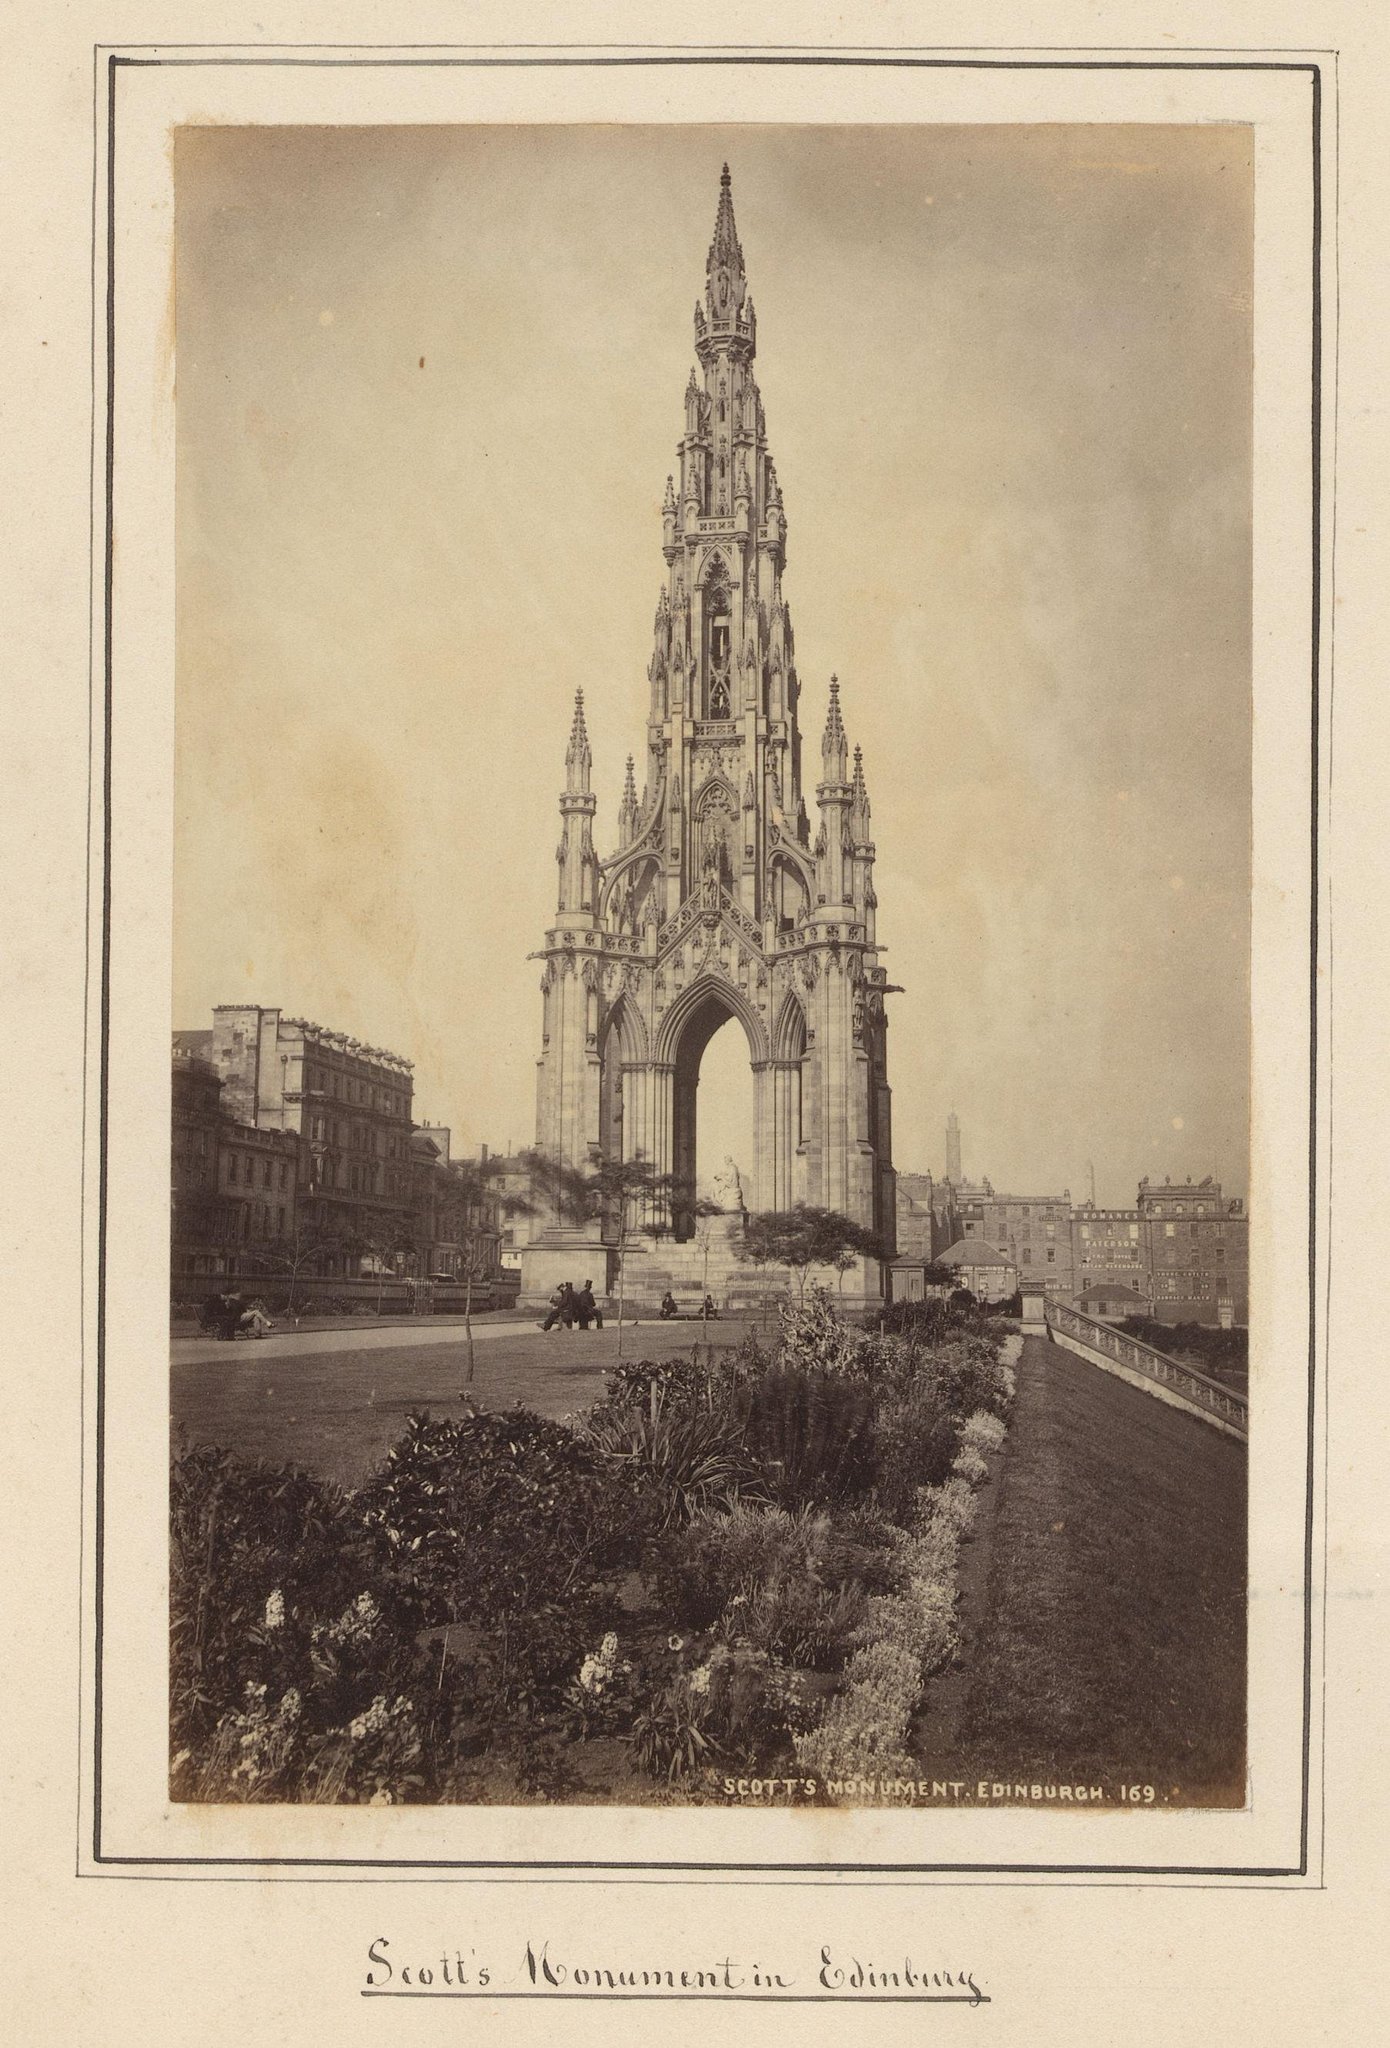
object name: reproduction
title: Fotoreproductie van het beeld van Sir Walter Scott door John Steell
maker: Anonymous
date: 1865-1890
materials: paper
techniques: albumen print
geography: edinburgh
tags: walter scott, monument, statue